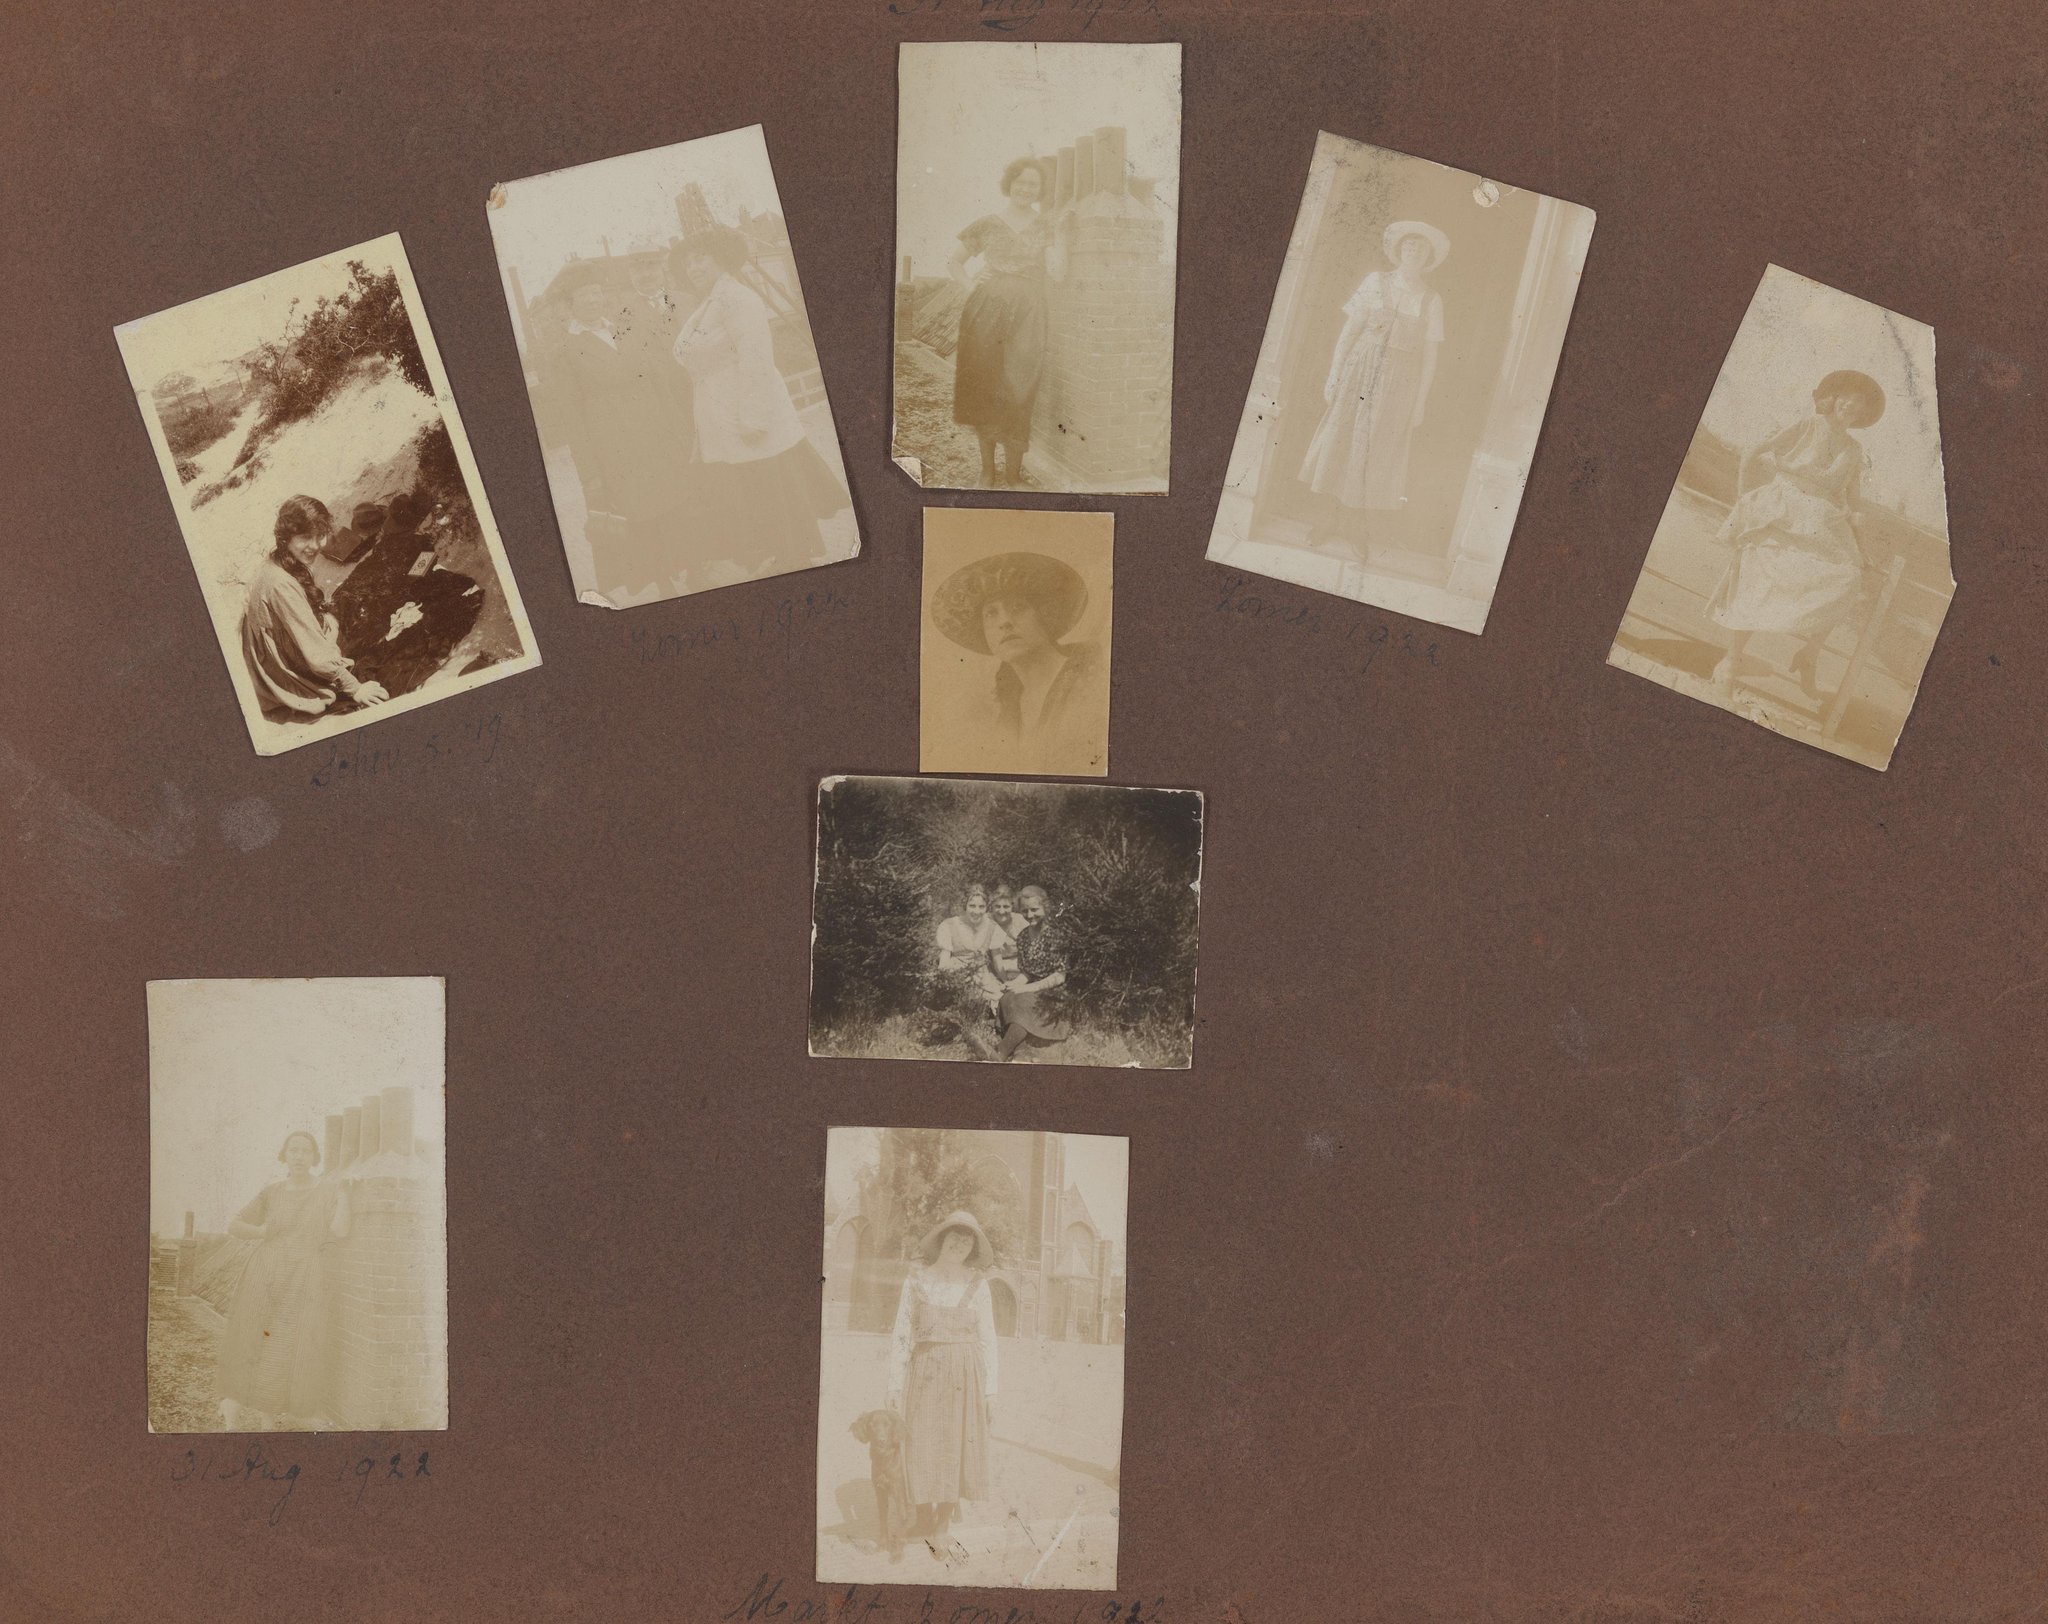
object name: photograph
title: Jonge vrouw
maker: Anonymous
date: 1922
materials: cardboard, photographic support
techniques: collodion silver print, gelatin silver print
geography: netherlands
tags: historical persons not known by name - bb - woman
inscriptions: inscription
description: Albumblad met negen foto's van een jonge vrouw, waarschijnlijk van de familie Jetten, poserend op diverse plekken, onder andere Scheveningen. Kleiner blad met afwijkende kleur karton. Onderdeel van het ensemble van albumbladen en losse foto's over ingenieur Jetten en familie in Moengo, Suriname.